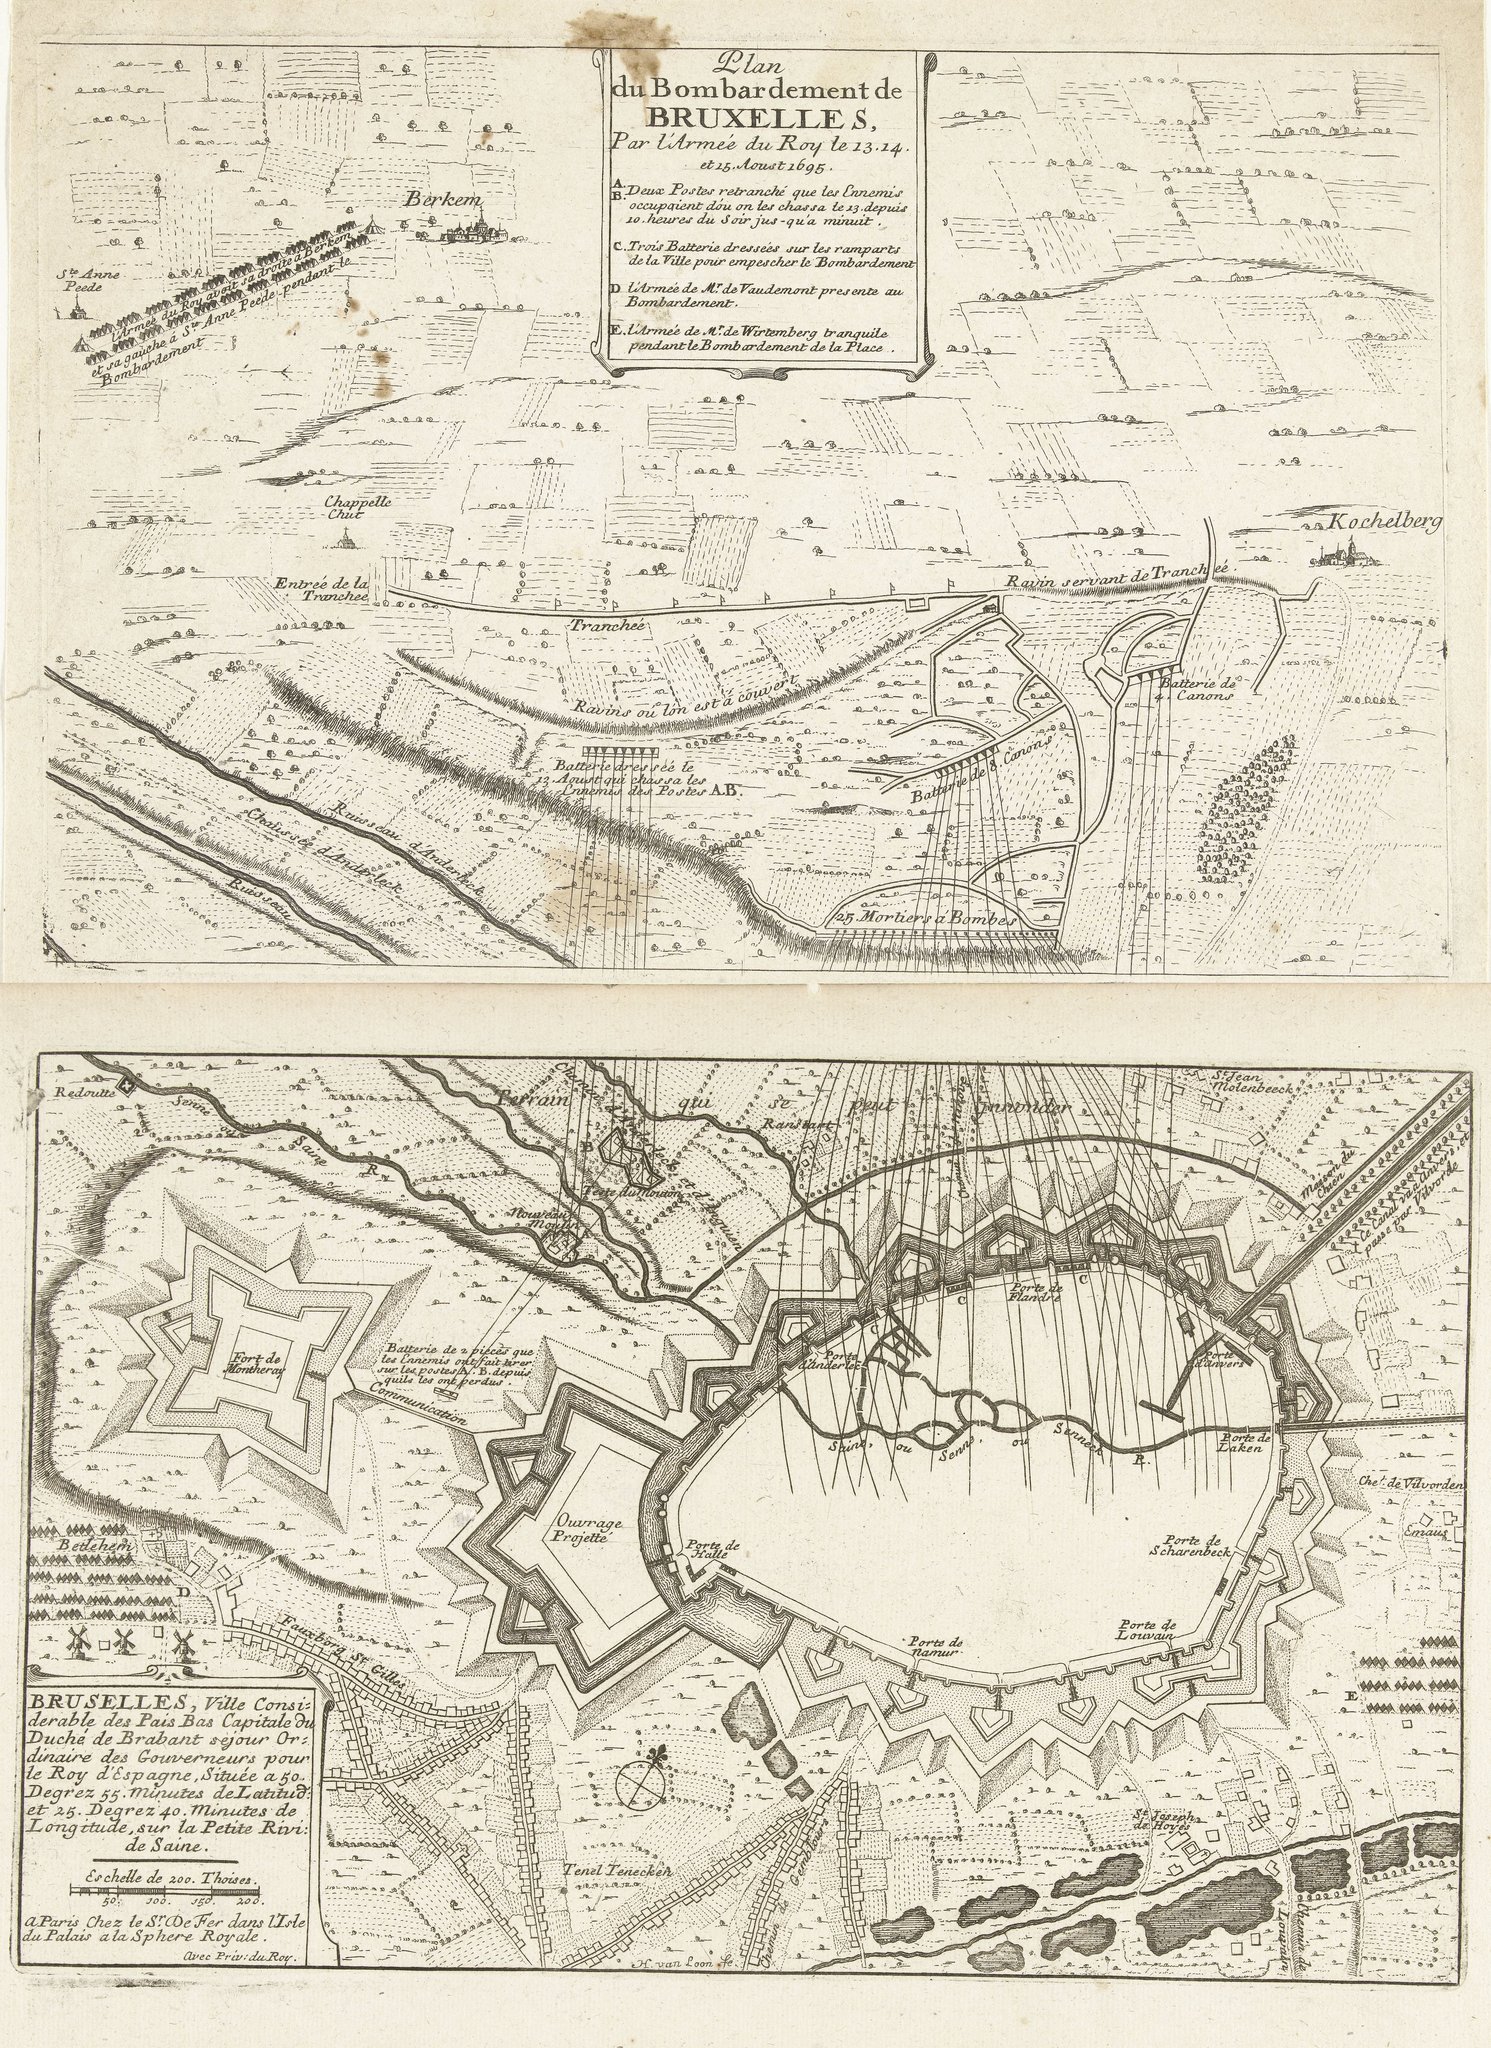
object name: print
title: Plan du Bombardement de Bruxelles, Par l'Armee du Roy le 13, 14 et 15 Aoust 1695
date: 1695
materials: paper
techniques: etching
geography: paris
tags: maps of separate countries or regions, brussels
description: Franse plattegrond van het bombardement van Brussel door de Fransen, 13-15 augustus 1695. In twee losse delen. In het bovenste deel de stellingen van waaruit de Fransen de stad hebben gebombardeerd, met cartouche met legenda A-E. In het onderste deel de plattegrond van de stad, met cartouche en het adres van de uitgever te Parijs.